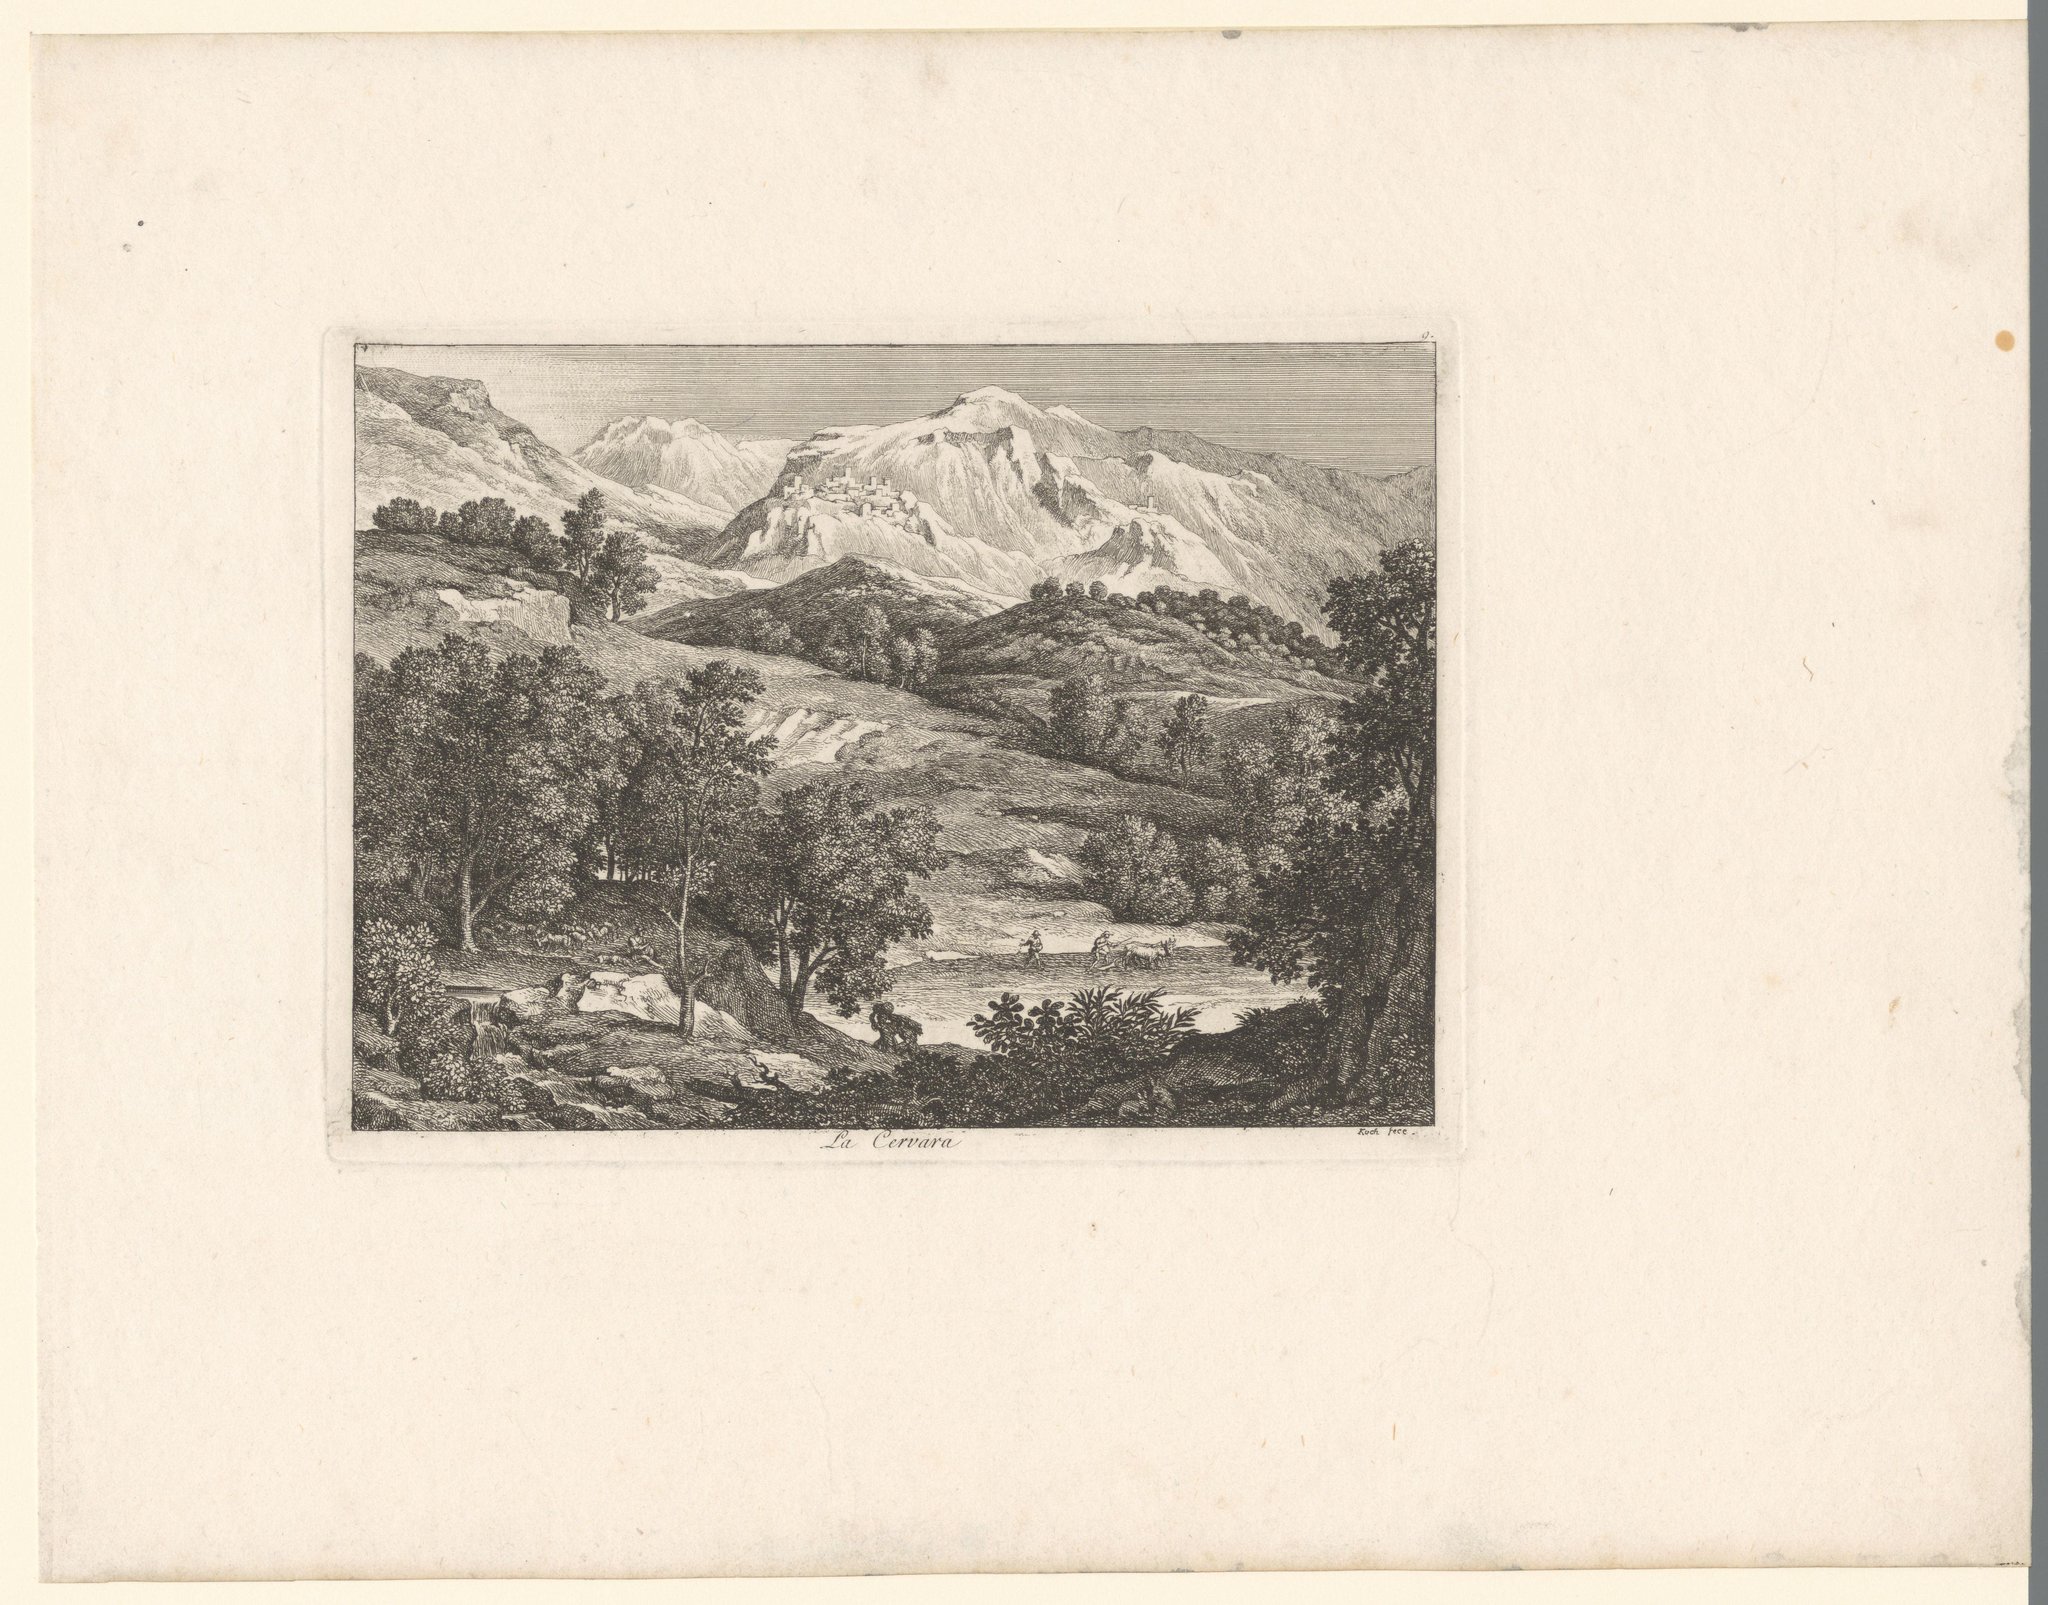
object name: print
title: Die Römischen Ansichten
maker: joseph anton koch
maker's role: draughtsman, painter, print maker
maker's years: 1768-1839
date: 1803-1805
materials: paper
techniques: etching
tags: city-view, and landscape with man-made constructions, low hill country, (high) hill, soil cultivation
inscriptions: number: ‘9’, collector's mark: Lugt 2228, collector's mark: Lugt 2760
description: Deze prenten komen mogelijk uit de collectie van Robert von Langer (1783-1846) uit München.